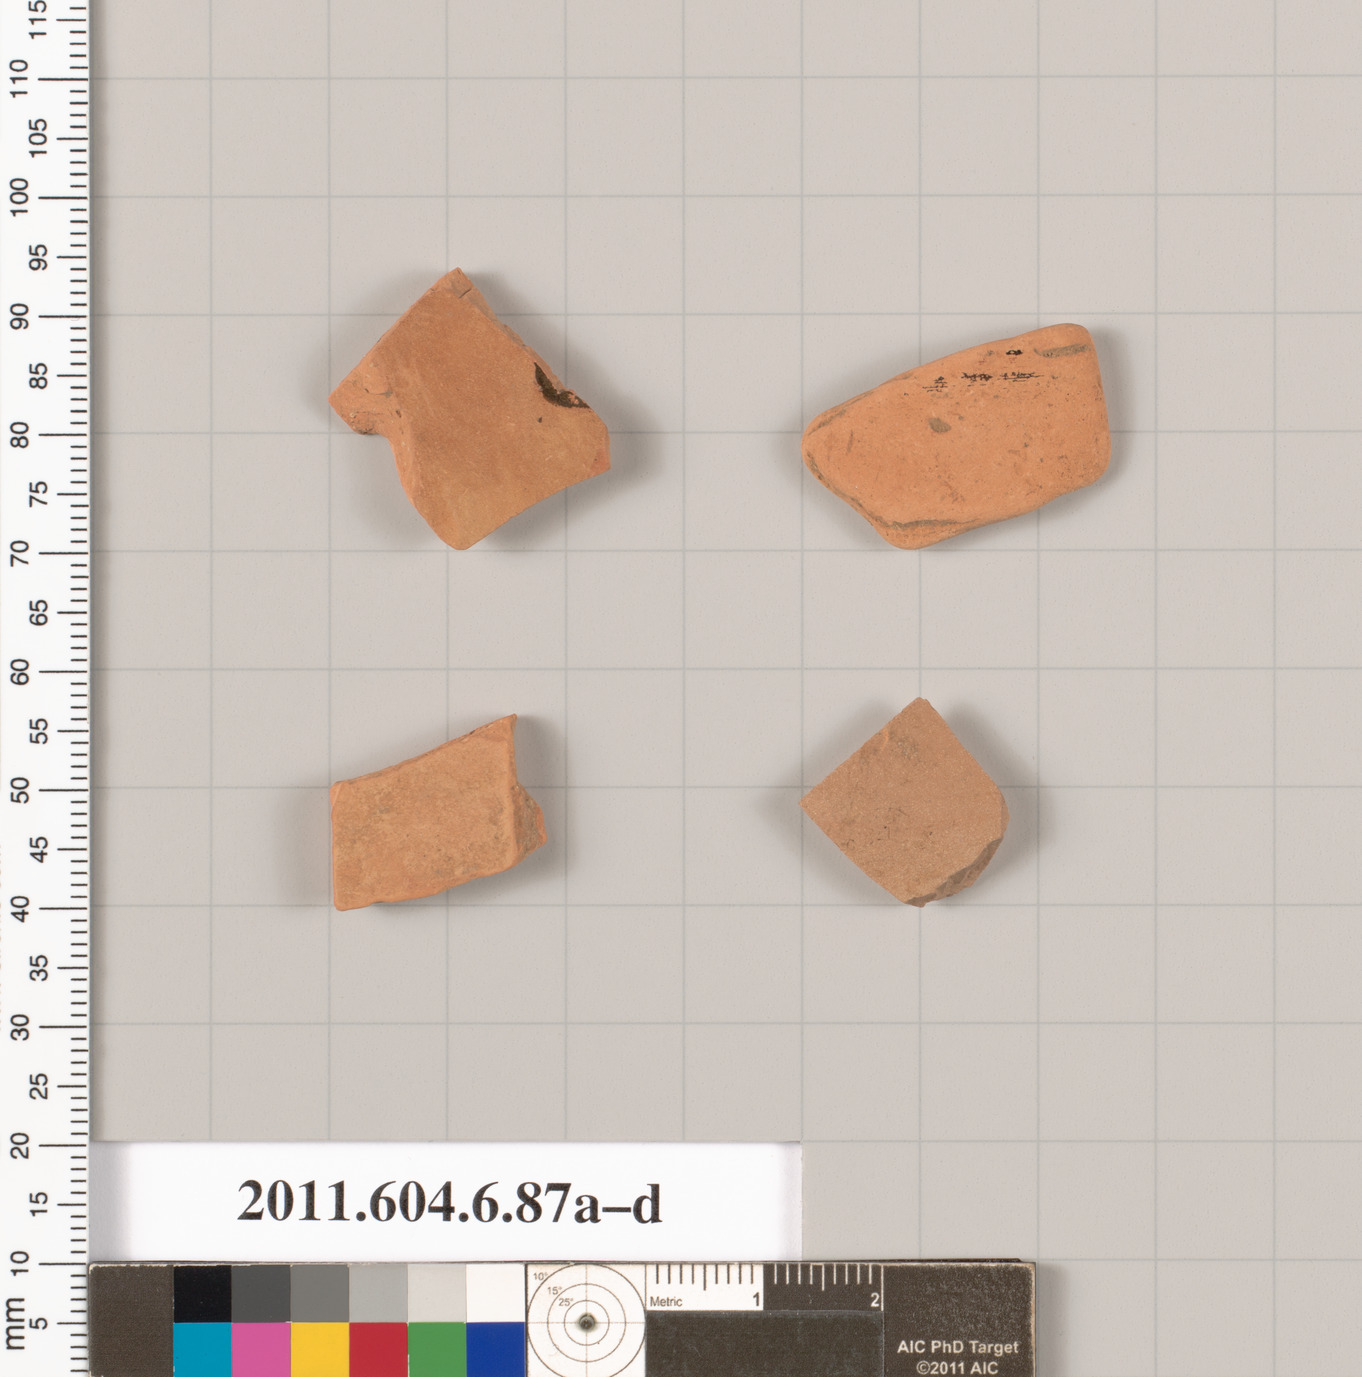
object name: undetermined shape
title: Terracotta fragments of undetermined shapes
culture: greek, attic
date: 600-401 BCE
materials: terracotta